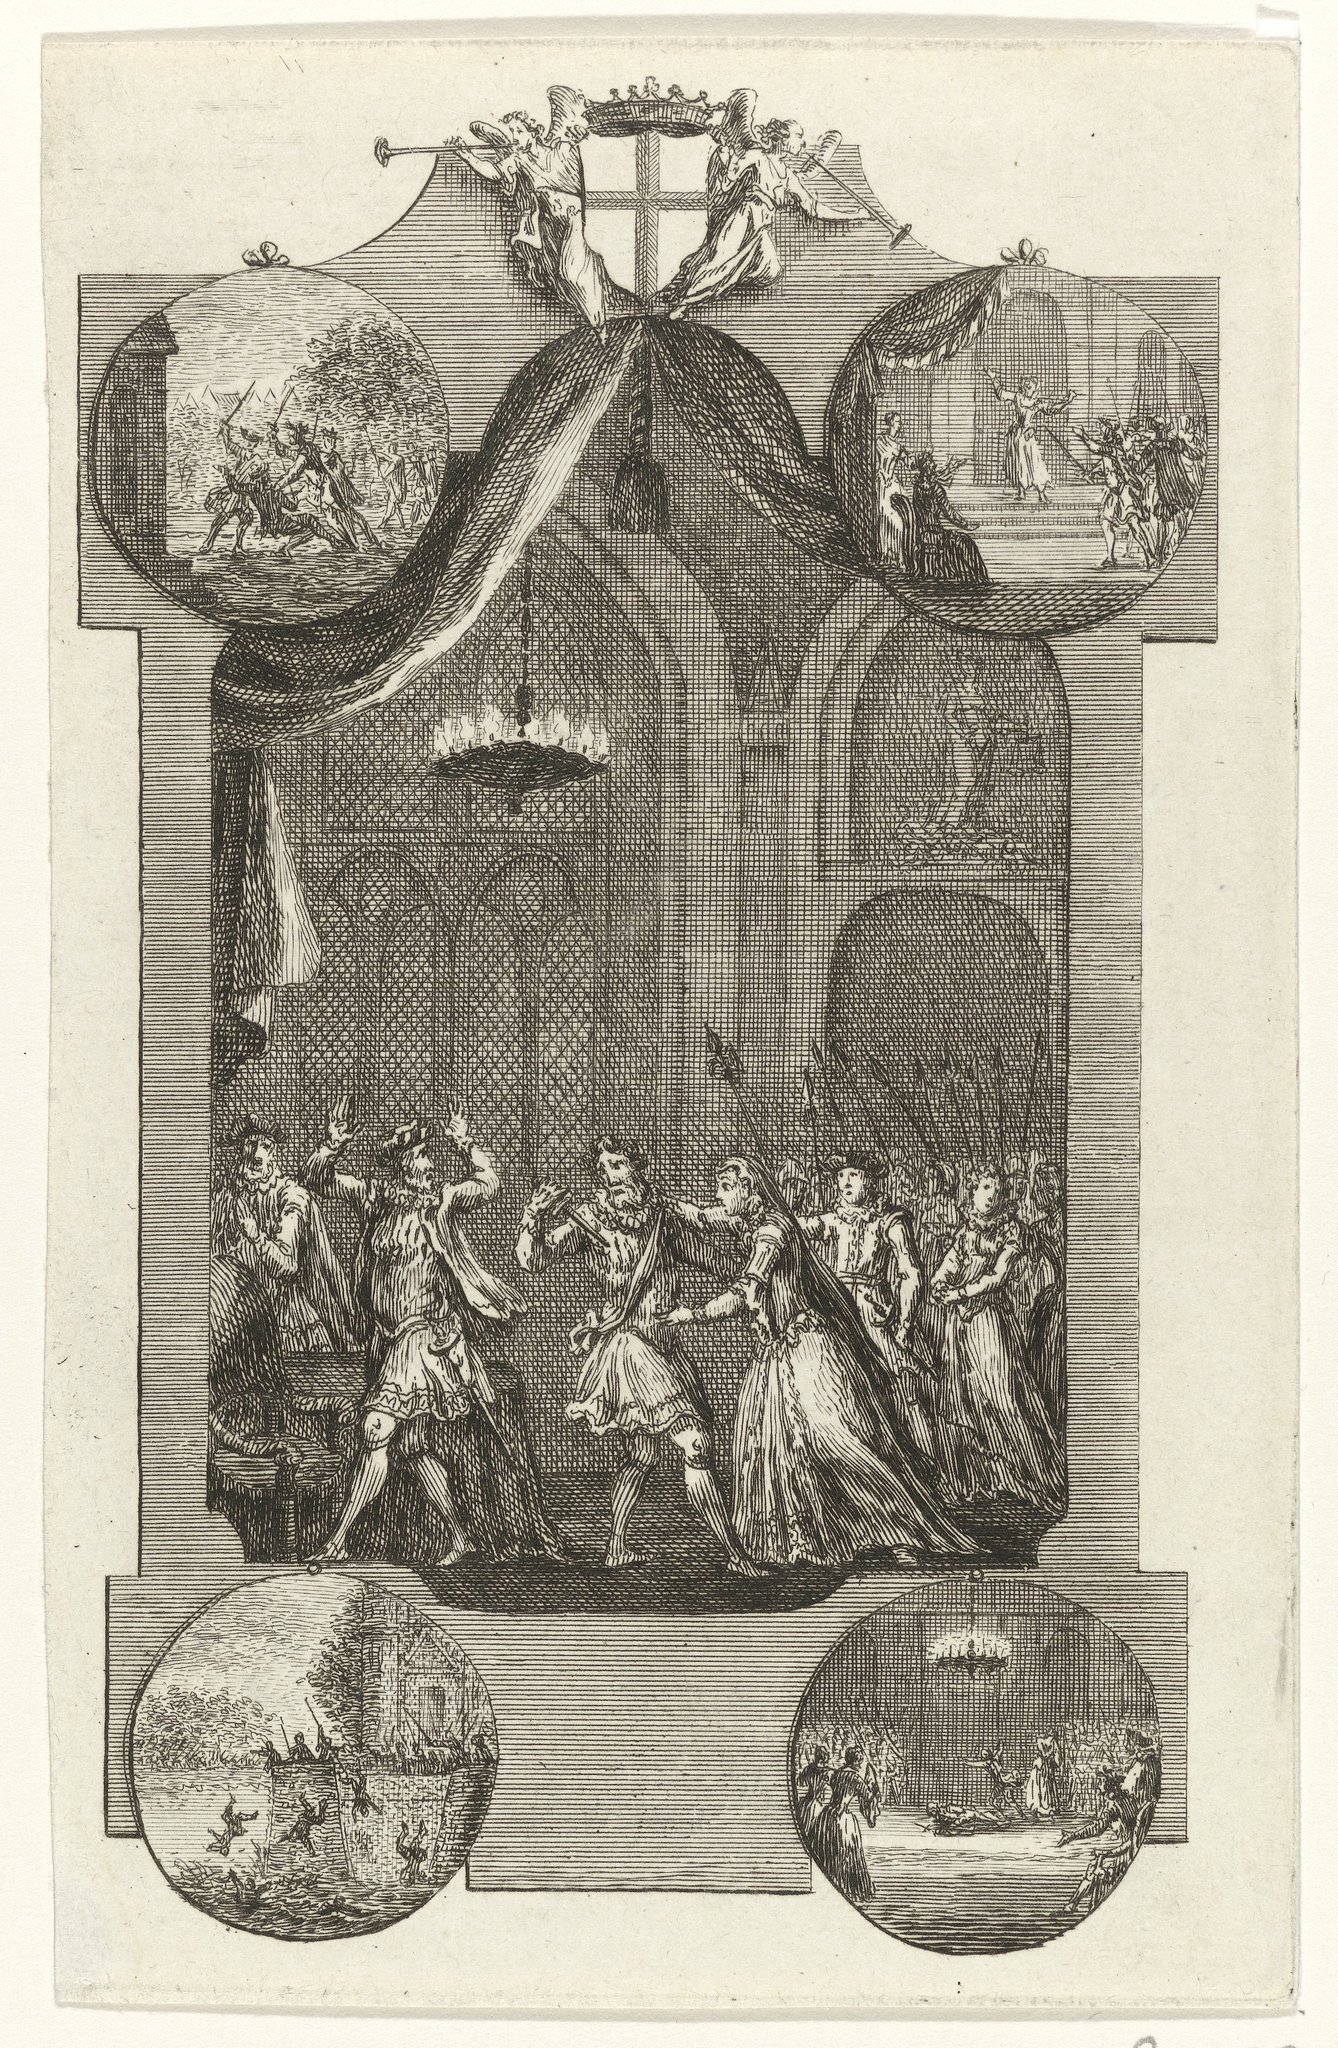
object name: print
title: Mislukte aanslag op Amersfoort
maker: simon fokke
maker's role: draughtsman, print maker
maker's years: 1712-1784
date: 1722-1784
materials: paper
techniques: etching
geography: amsterdam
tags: attempt, political murder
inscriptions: collector's mark: Lugt 2760, collector's mark: Lugt 2228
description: Midden in een zaal staat een man met geheven dolk tegen zijn borst. Hij wordt tegengehouden door een vrouw die hem bij de schouder vastpakt. Links loopt een man met geheven armen van de man met dolk weg. Op de achtergrond wachten figuren met lansen. Om de voorstelling heen staan vier kleine medaillons met gevechtsscènes. Het geheel is gekroond met het stadswapen van Amersfoort, geflankeerd door twee bazuin blazende engelen.